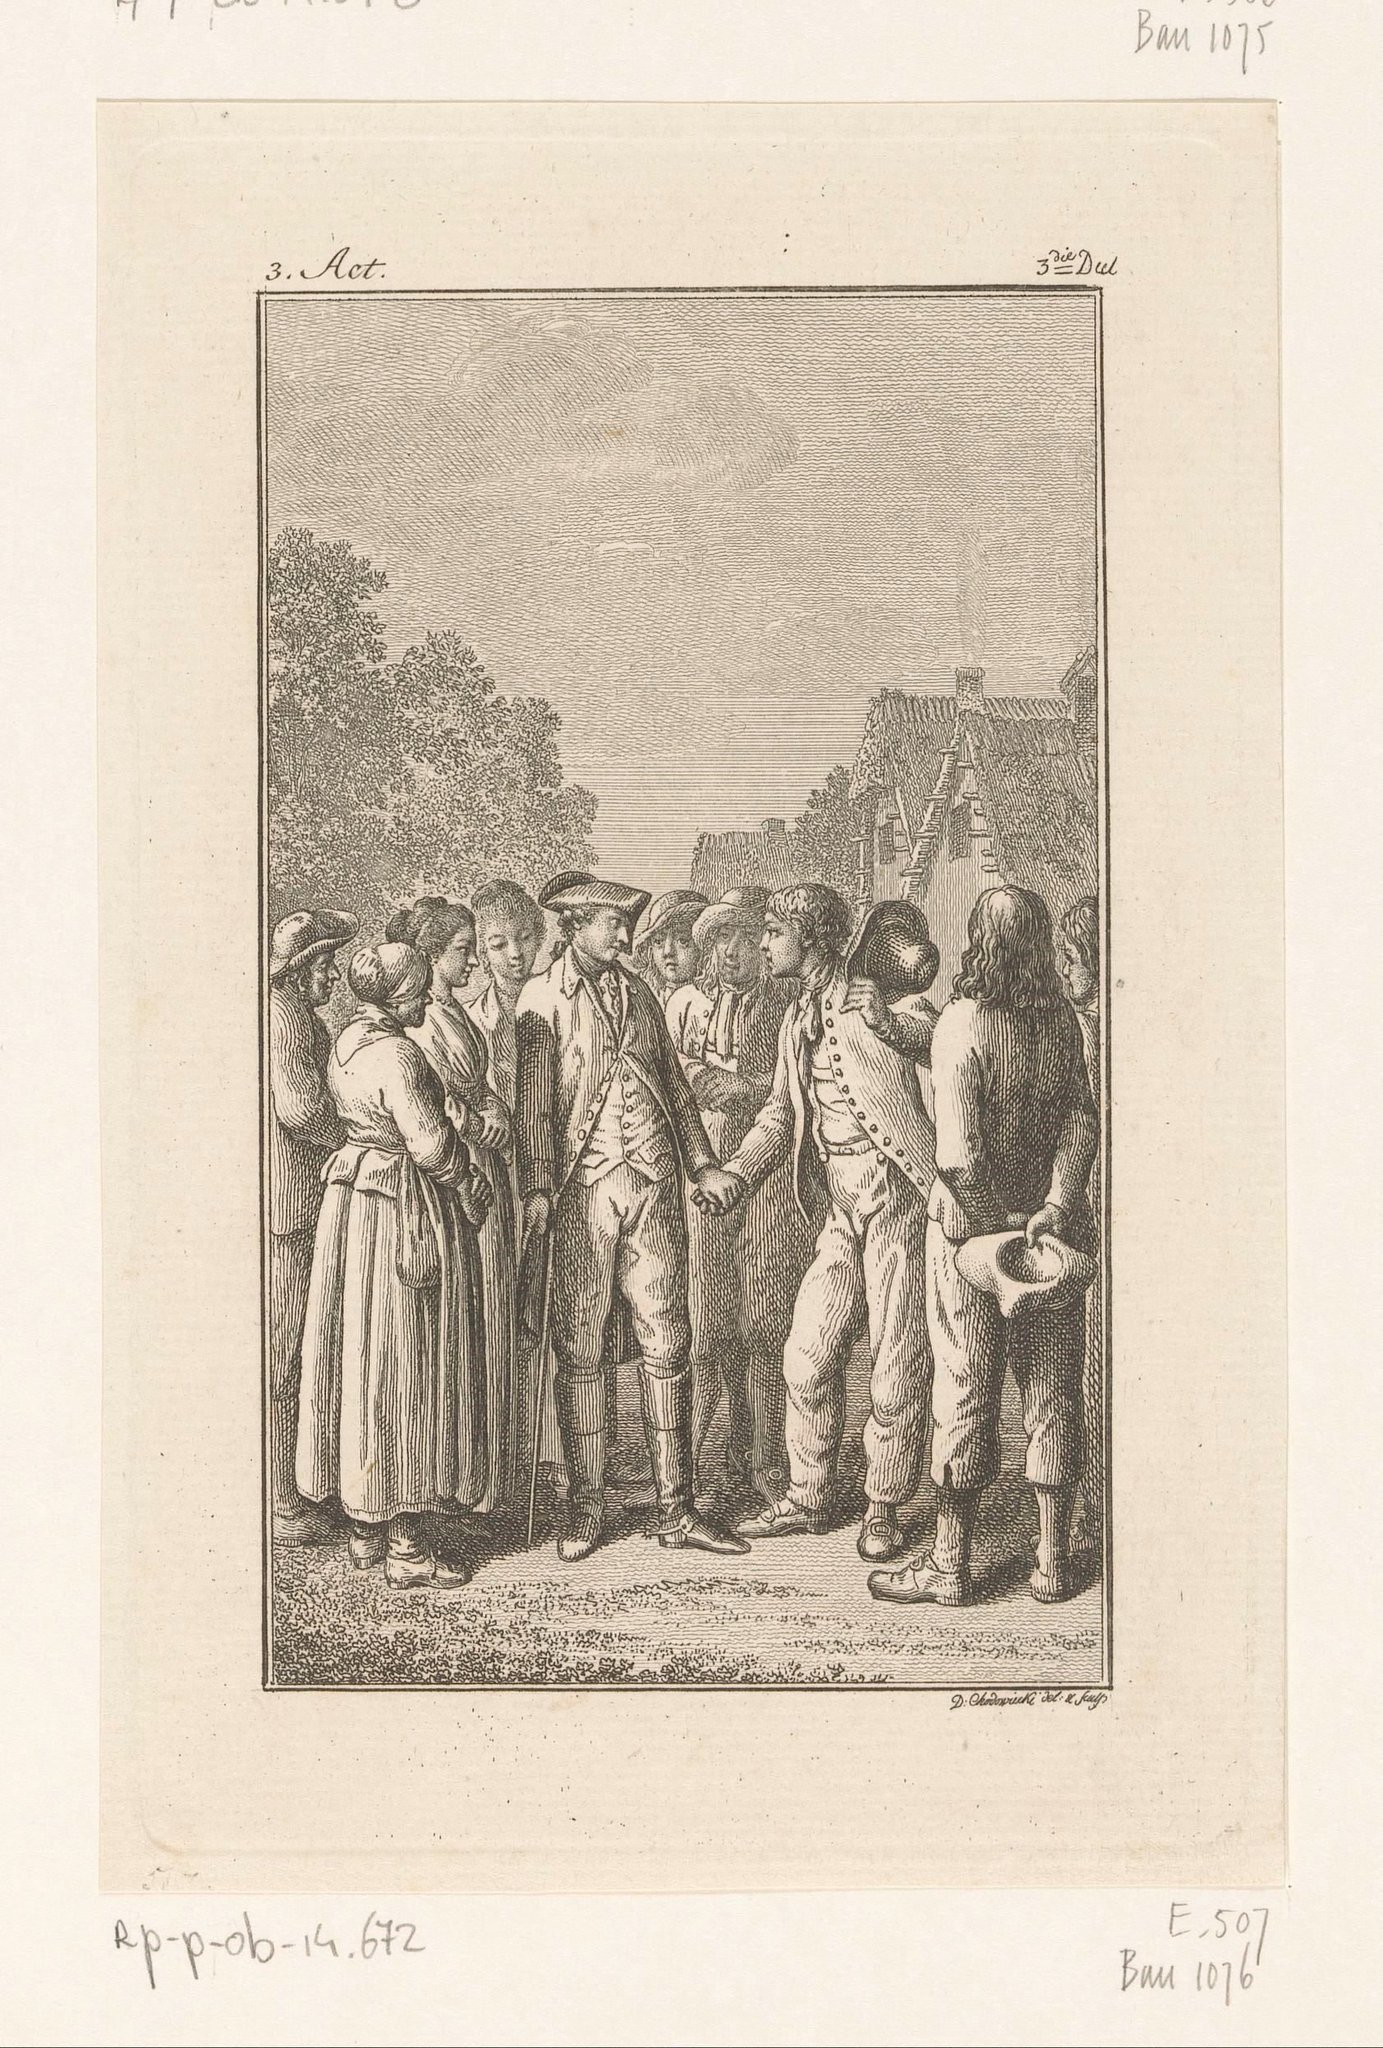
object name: print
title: Herr von Pless dankt Franz en de dorpelingen voor zijn redding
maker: daniel nikolaus chodowiecki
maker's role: draughtsman, print maker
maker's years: 1726-1801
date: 1784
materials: paper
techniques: etching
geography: berlin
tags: copenhagen (city), shaking hands, 'dextrarum junctio', literature, village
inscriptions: collector's mark: Lugt 2228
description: Prent uit: Ewald, Johannes. Johannes Ewald's samtlige Skrifter (...). 4 dln. Kopenhagen: Christ. Gottlob Proft, 1781-1791, dl. 3.